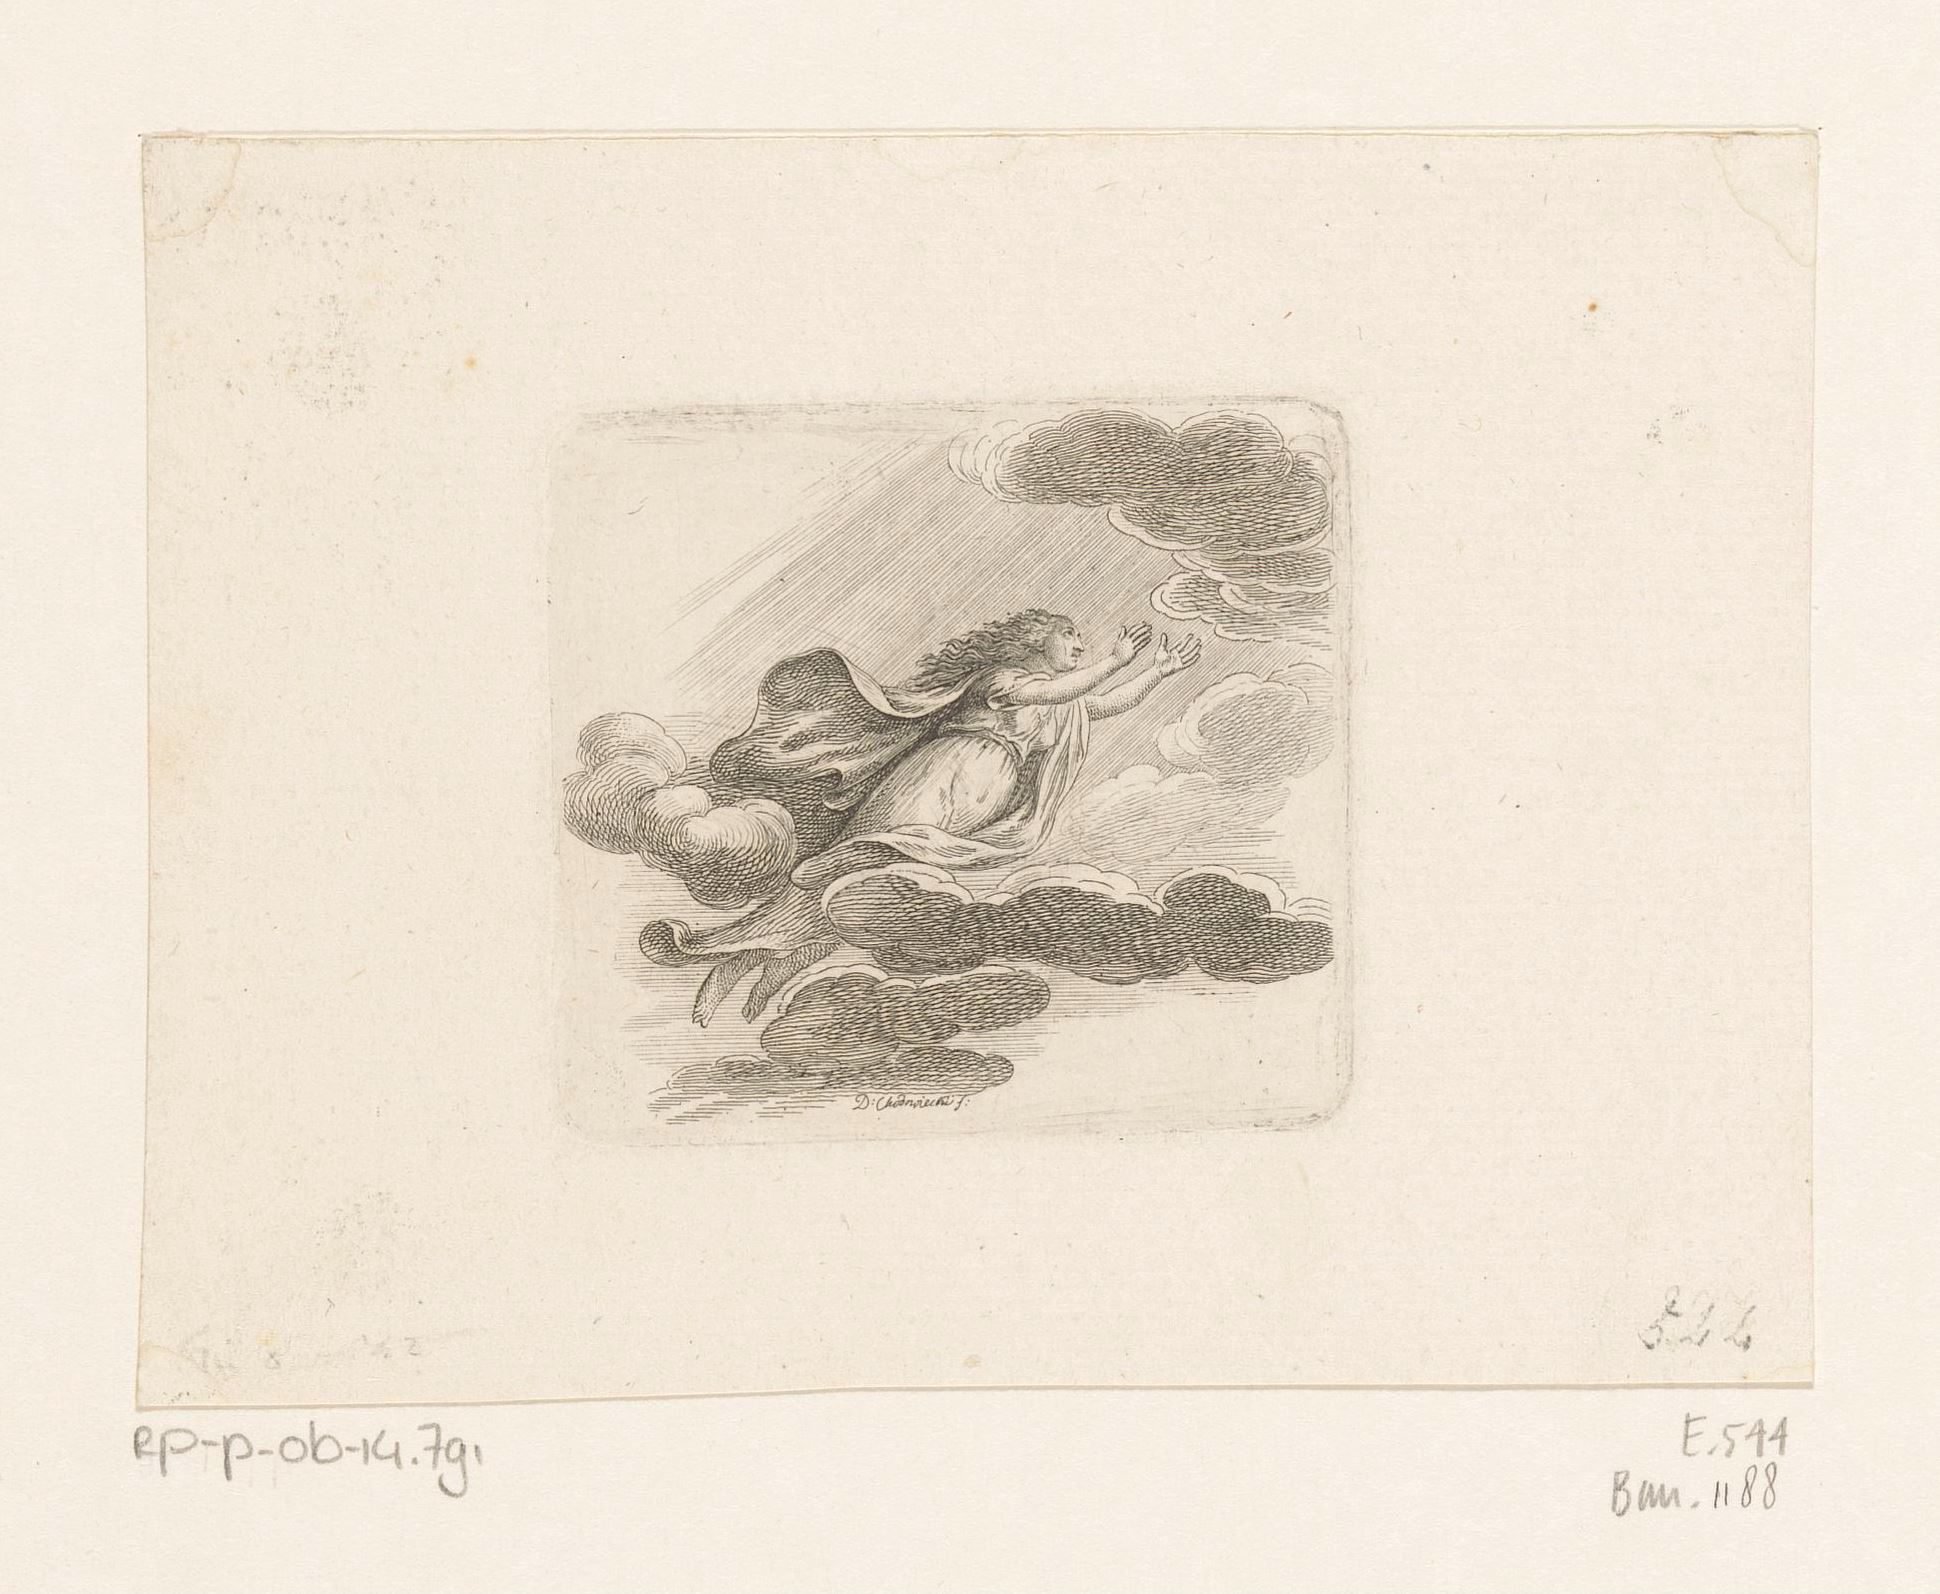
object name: print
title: Hemelvaart van een vrouw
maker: daniel nikolaus chodowiecki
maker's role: draughtsman, print maker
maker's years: 1726-1801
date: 1785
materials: paper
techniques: etching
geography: berlin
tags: clouds, apotheosis (or ascension) of individuals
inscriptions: collector's mark: Lugt 2228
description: Prent gebruikt voor: Karschin, Anna Luise. Der Nachruhm am Begräbnisstage meiner seligen Freundin ihrem Chodowiecky. Berlijn: G. J. Decker, 1785. Uitgegeven naar aanleiding van het overlijden van de vrouw van Daniel Nikolaus Chodowiecki.